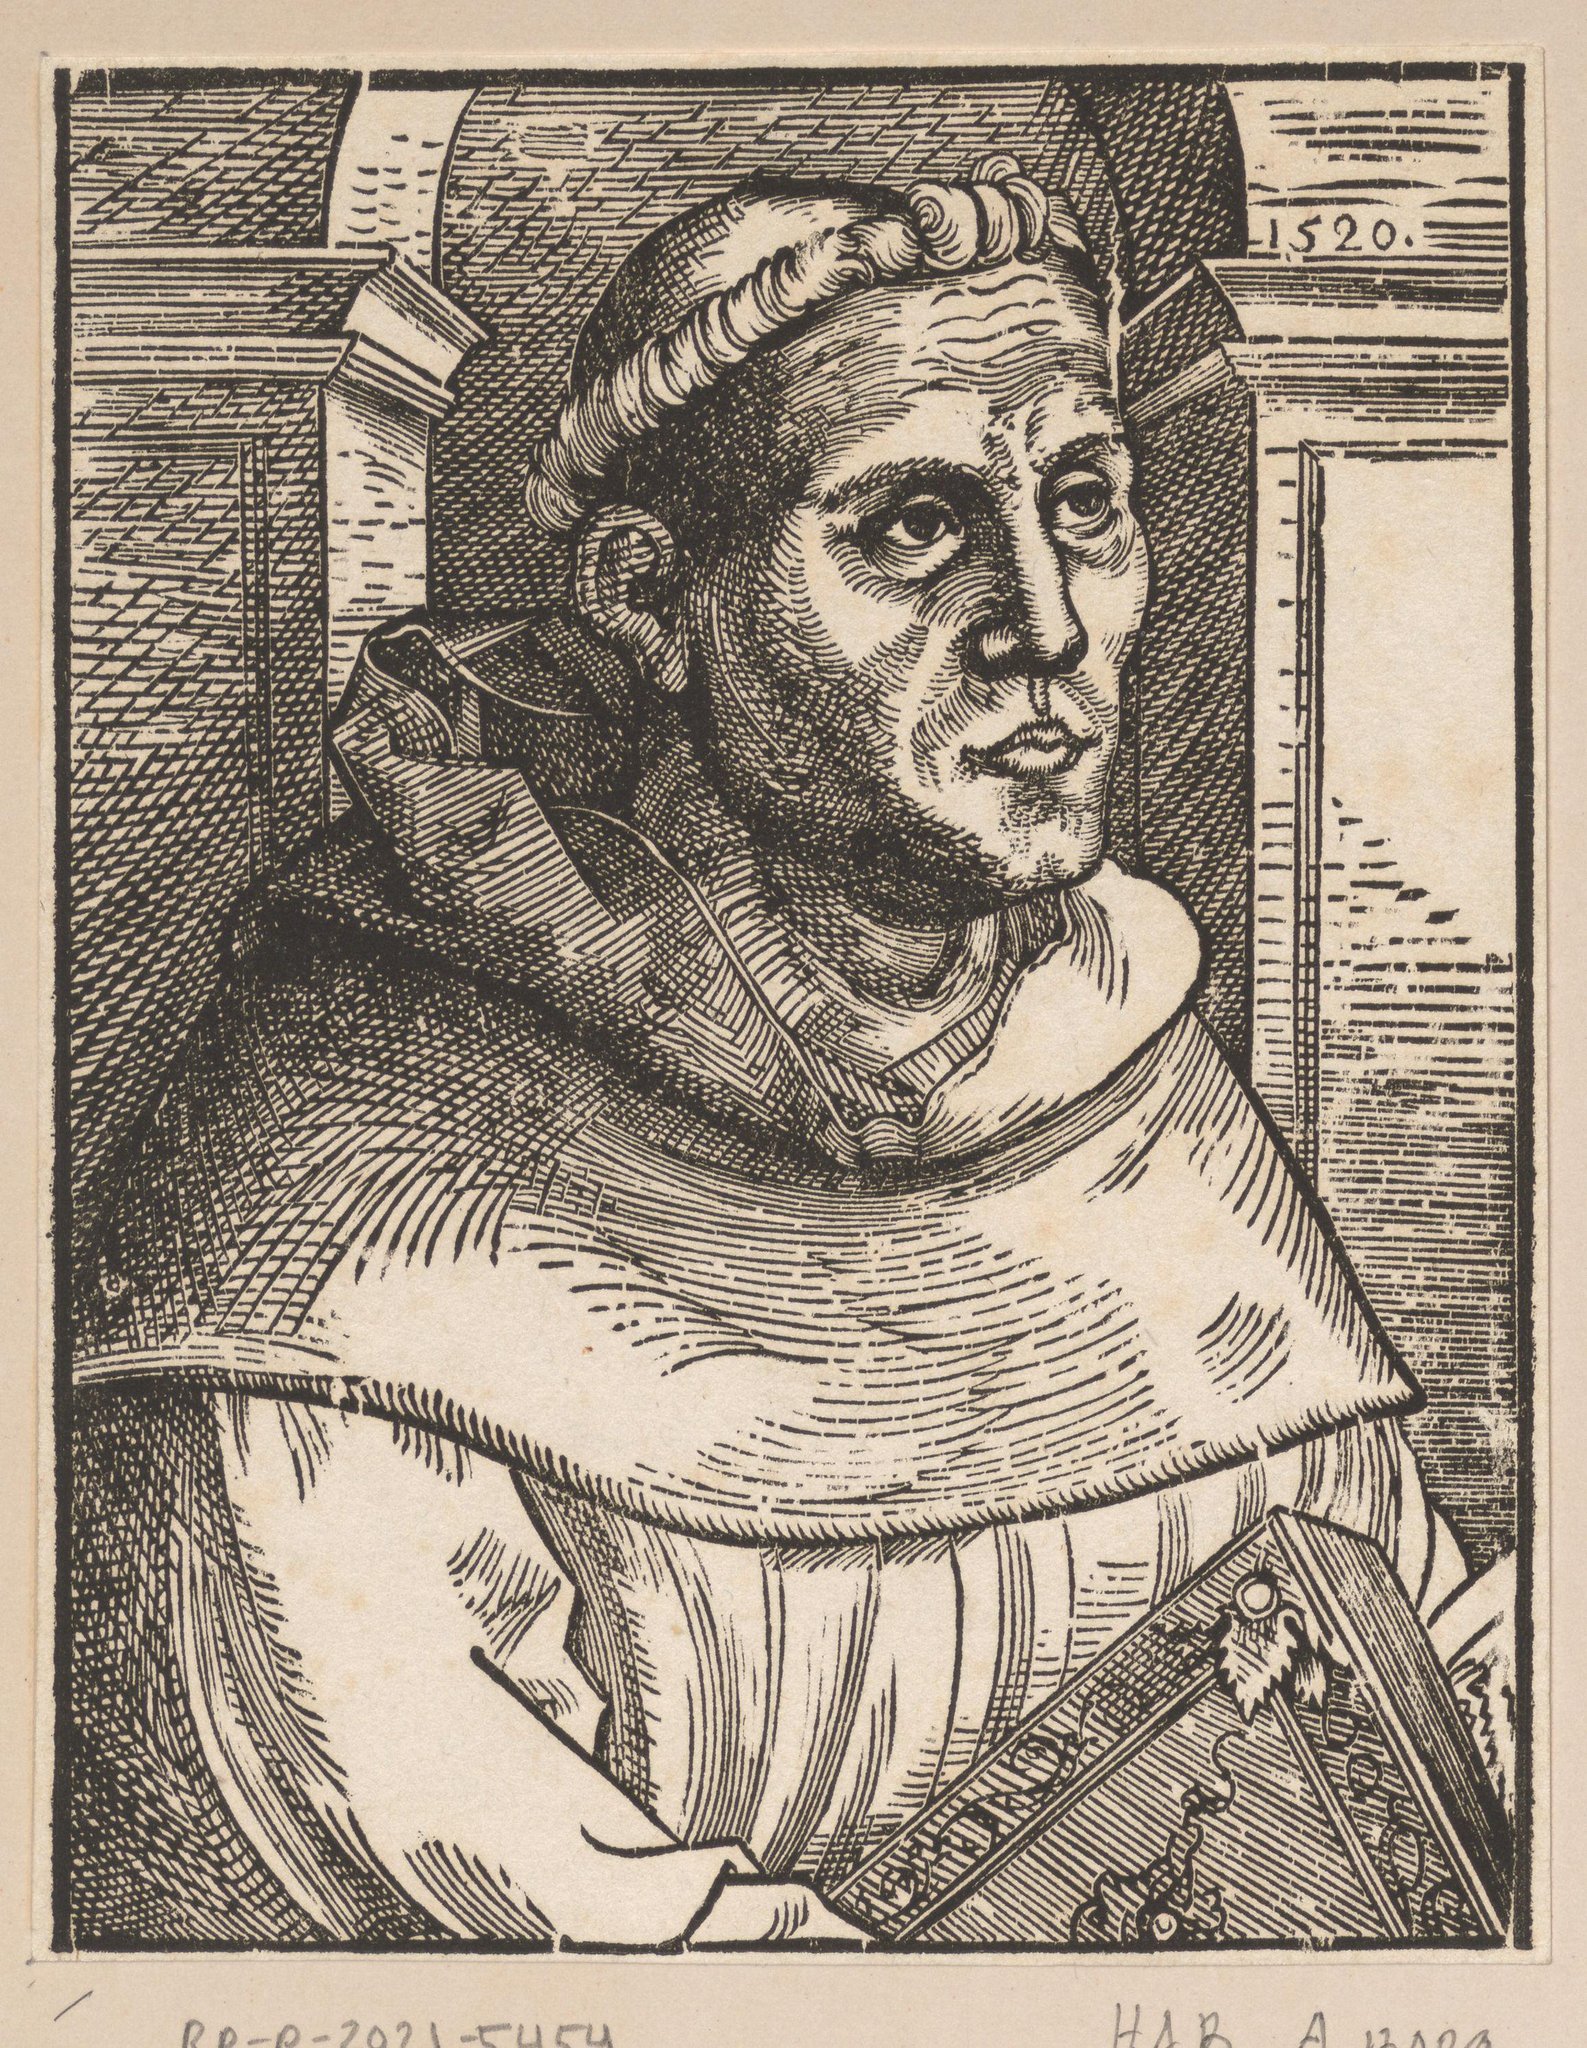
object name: print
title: Portret van Martin Luther als Augustijner monnik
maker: Anonymous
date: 1600-1650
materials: paper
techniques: woodcut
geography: germany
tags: priest, martin luther, historical persons, monk(s), friar(s)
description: Prent komt waarschijnlijk uit een editie van Luther's 'Von der Babylonischen gefencknuß der Kirchen', voor het eerst uitgegeven in 1520.